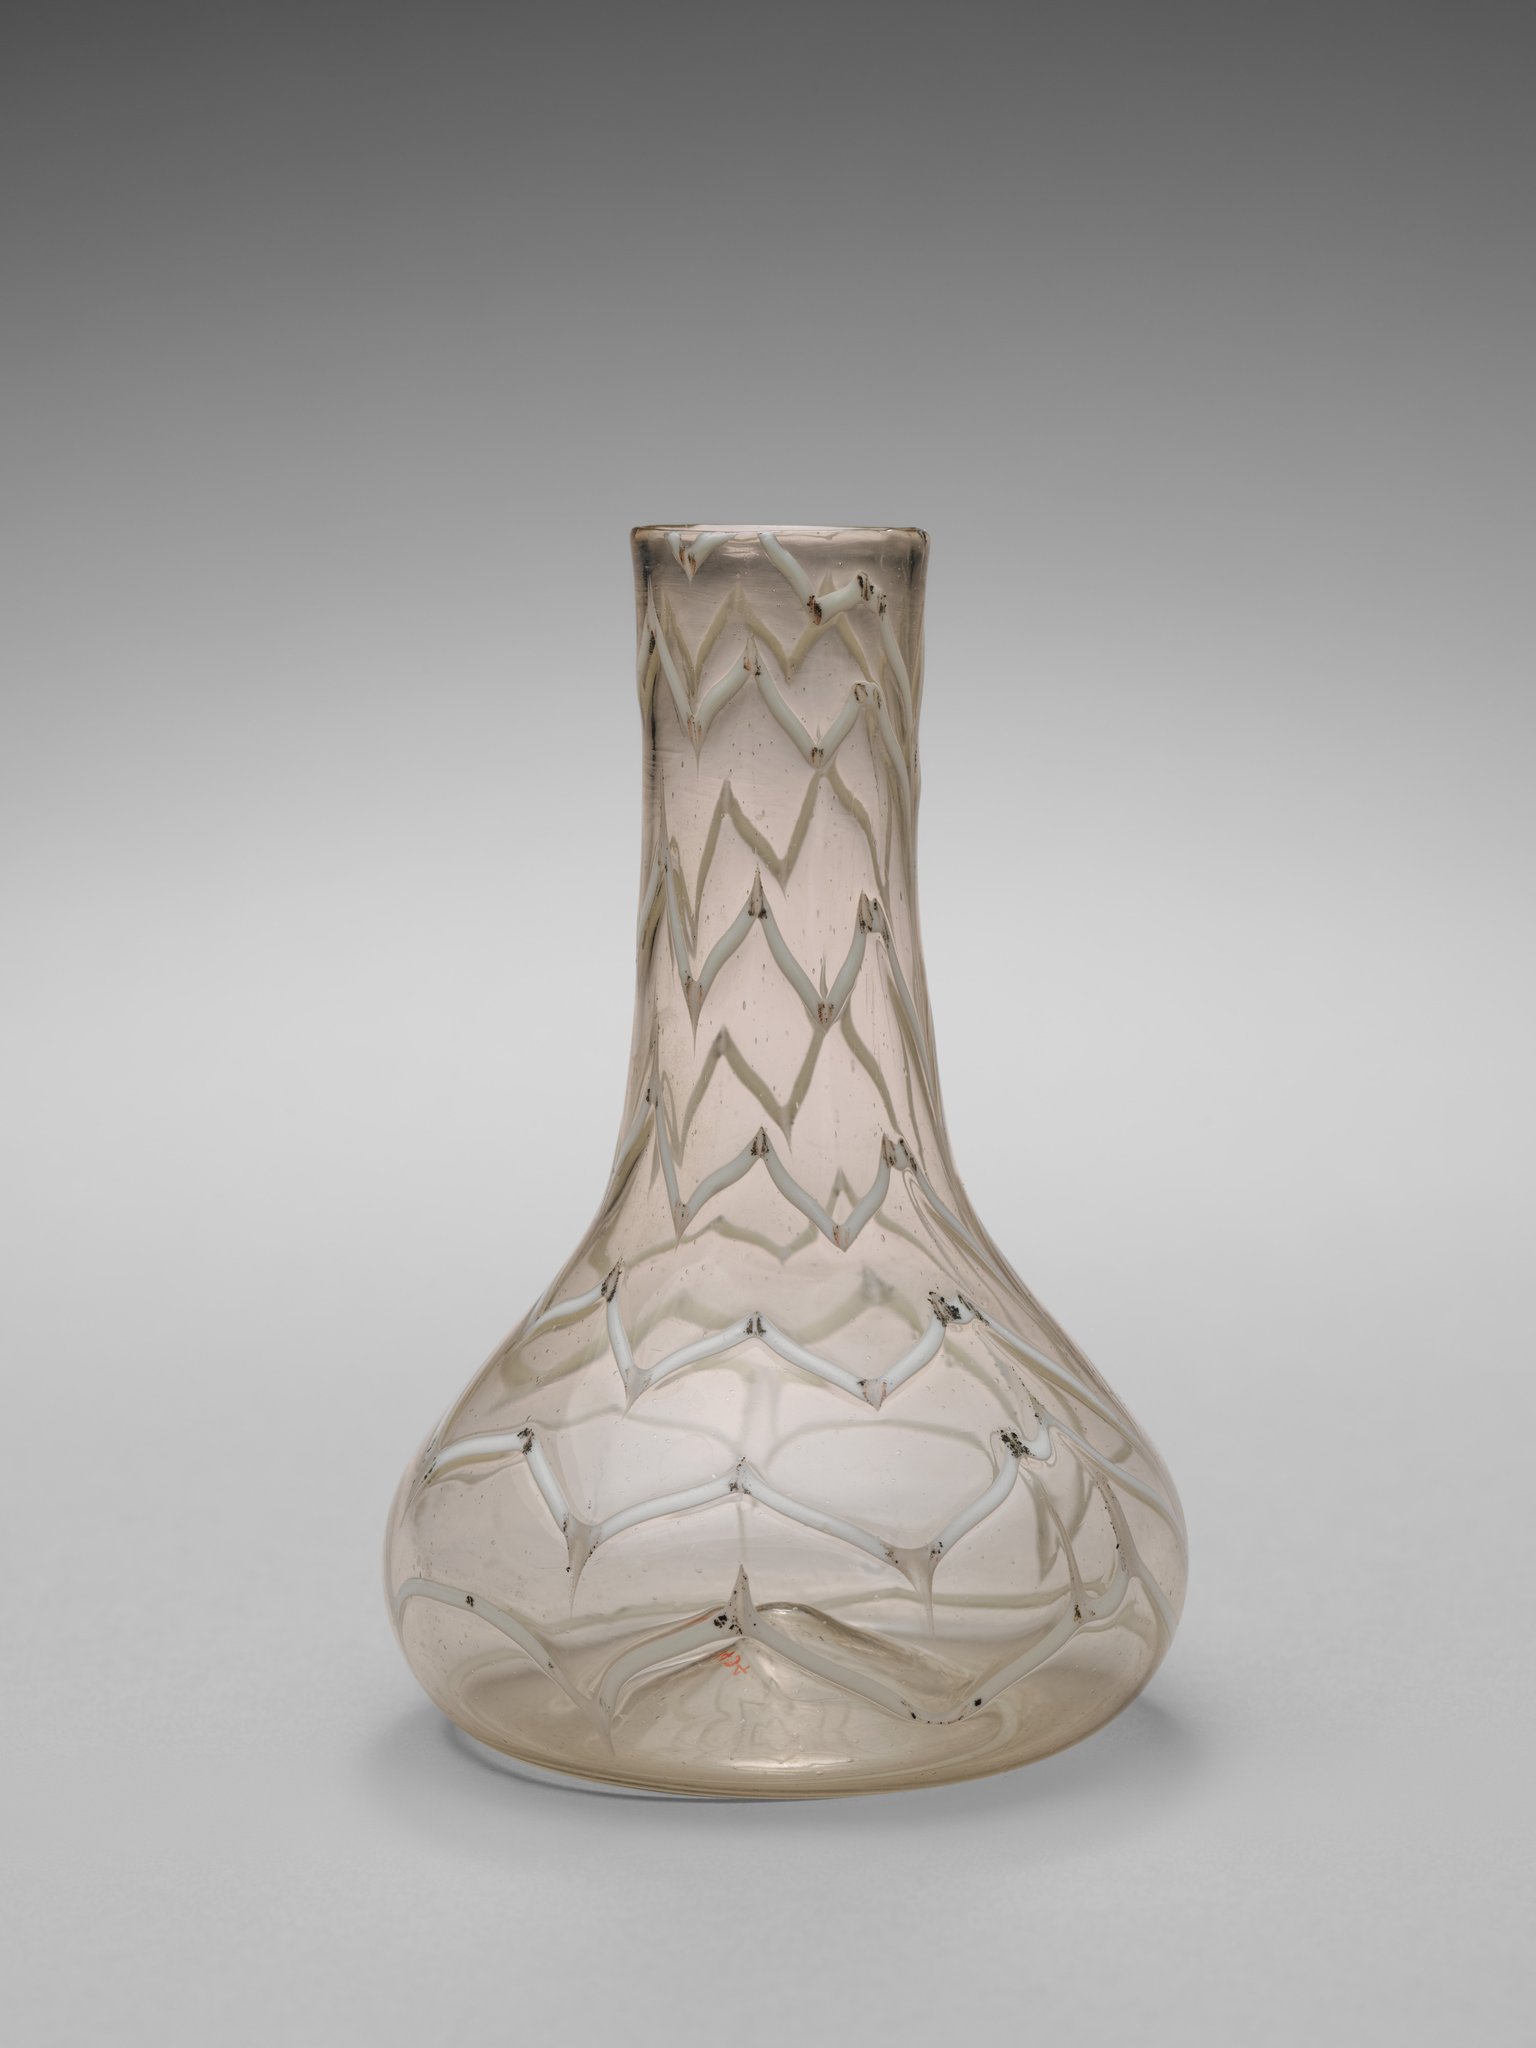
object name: bottle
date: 1601-1700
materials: glass